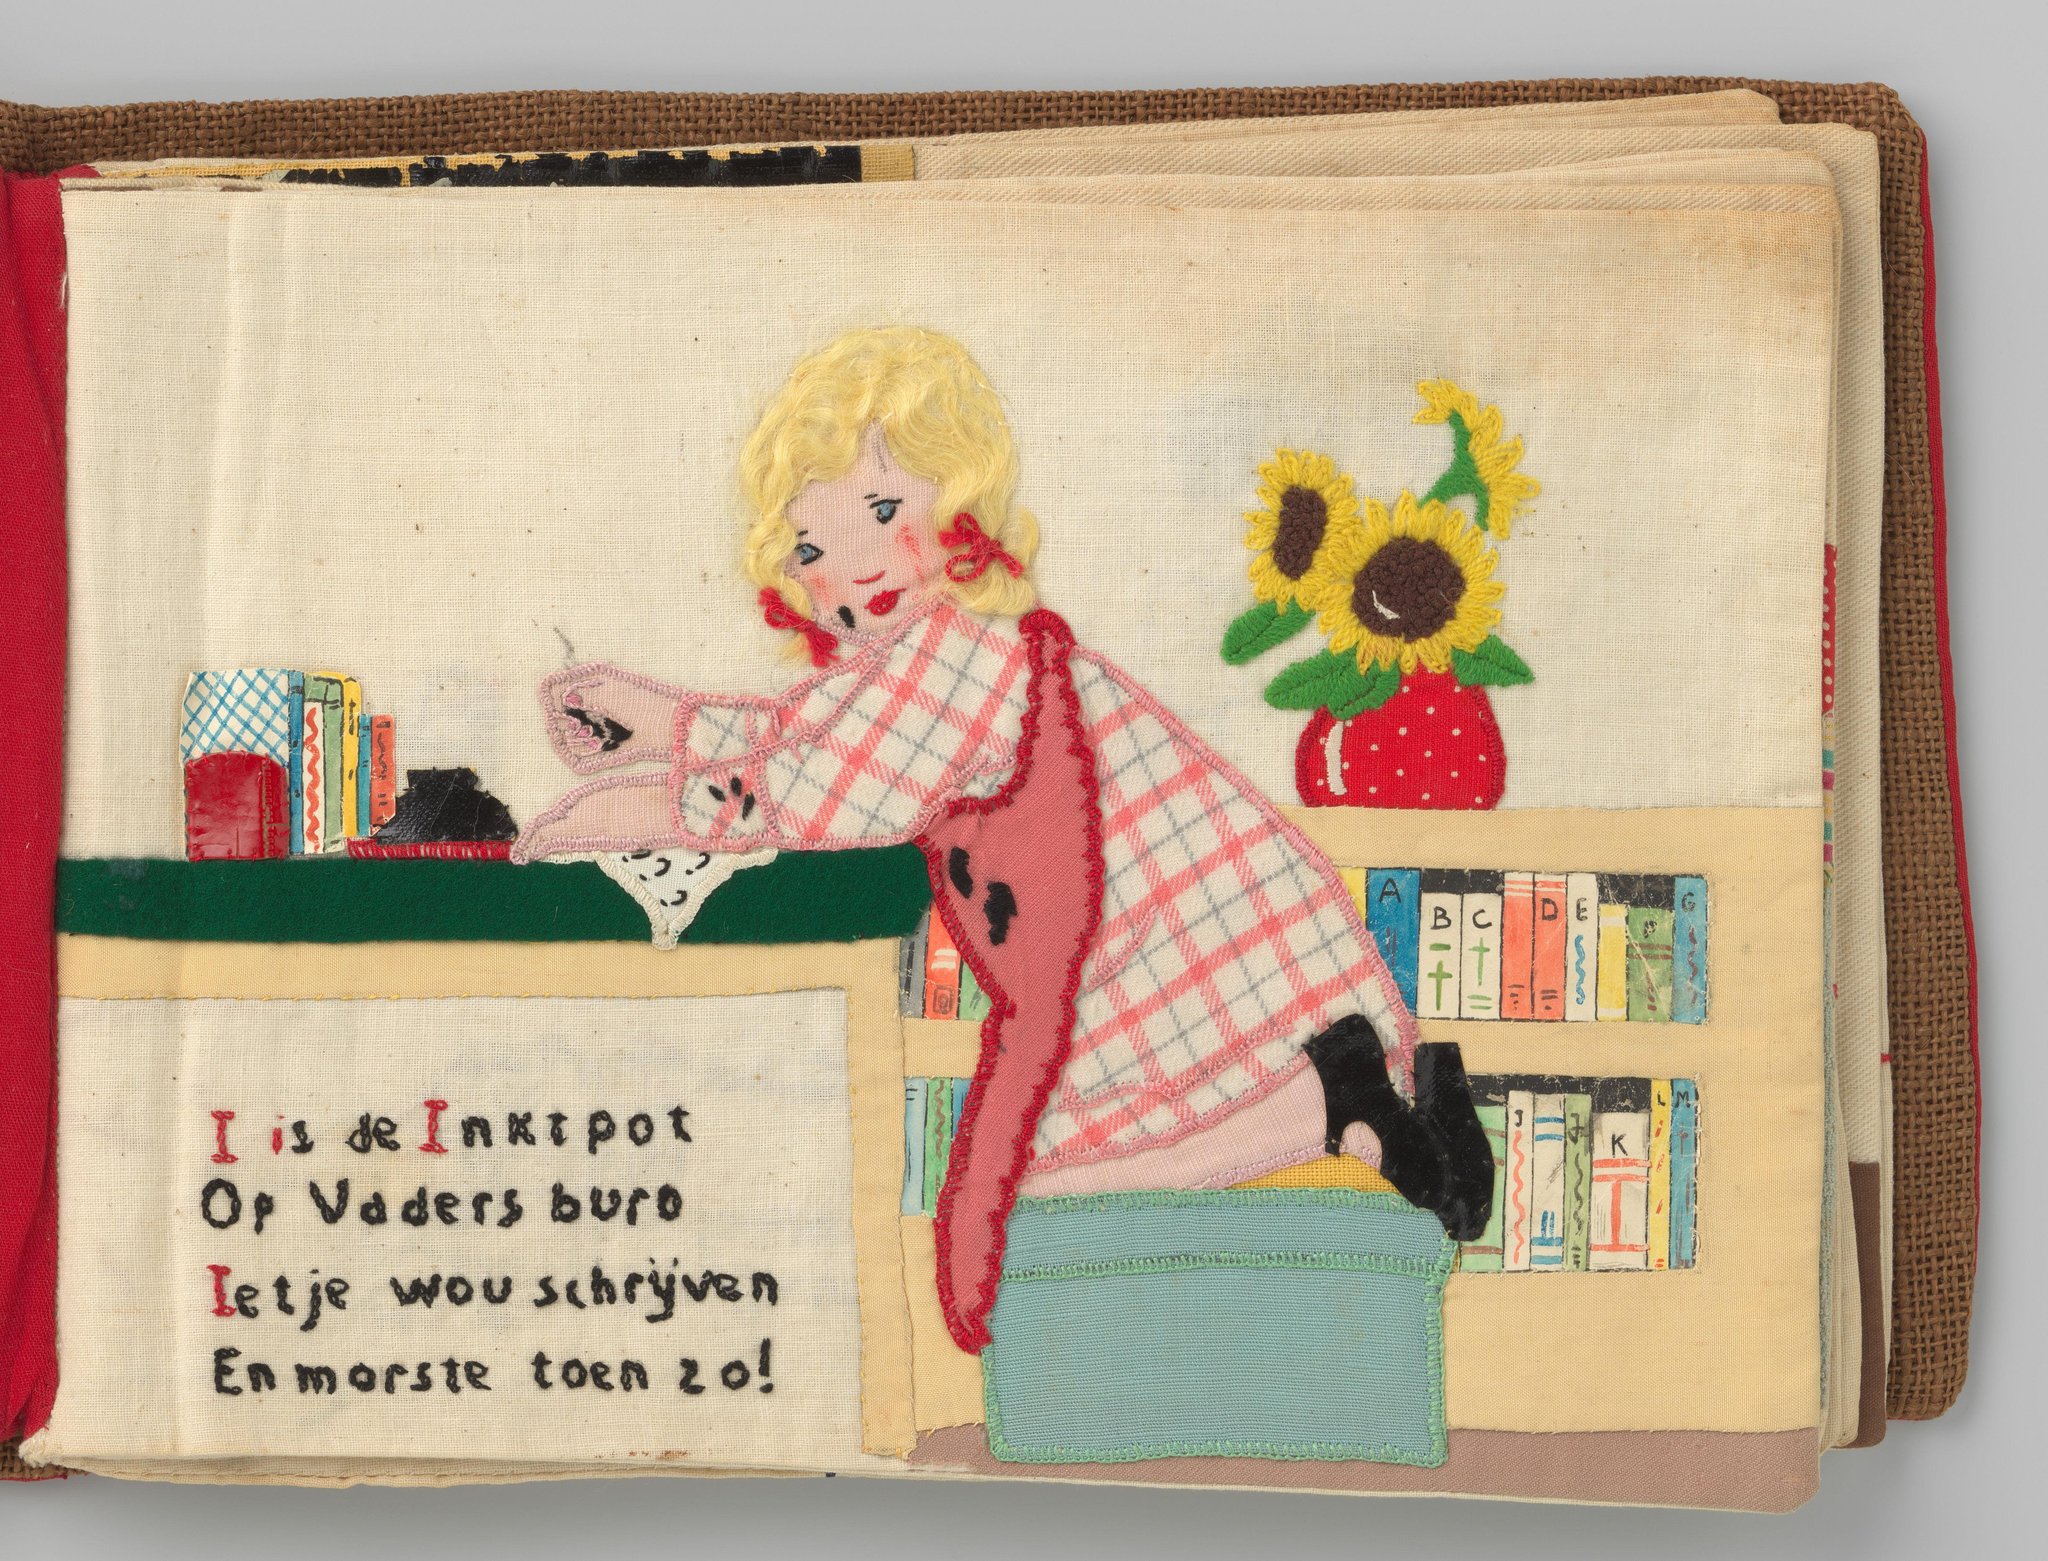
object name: blad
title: I is de Inktpot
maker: miesje geertruida maria petronella aalbersberg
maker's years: 1915-1997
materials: cotton, textile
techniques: appliqué, embroidered, stitch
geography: brastagi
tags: reading, book in which illustrations are essential, letters, alphabet, script, internment camp, nursery school (+ teaching aids), (other forms of) needlework, e.g.: crocheting, knitting, embroidering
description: In het geheim gemaakt kinderboek in textiel vrij naar A is een Aapje van Rie Cramer. Het werd gezamenlijk gemaakt door de vrouwelijke gevangenen van het Japanse interneringskamp Brastagi, een oude plantage in Noord-Sumatra 60 kilometer ten zuiden van Medan aan de weg naar het Toba-meer, tijdens de Tweede Wereldoorlog ter gelegenheid van de vijfde verjaardag van Pem Hagers, de dochter van Miesje Hagers-Aalbersberg die de ontwerptekeningen en sjablonen had gemaakt.